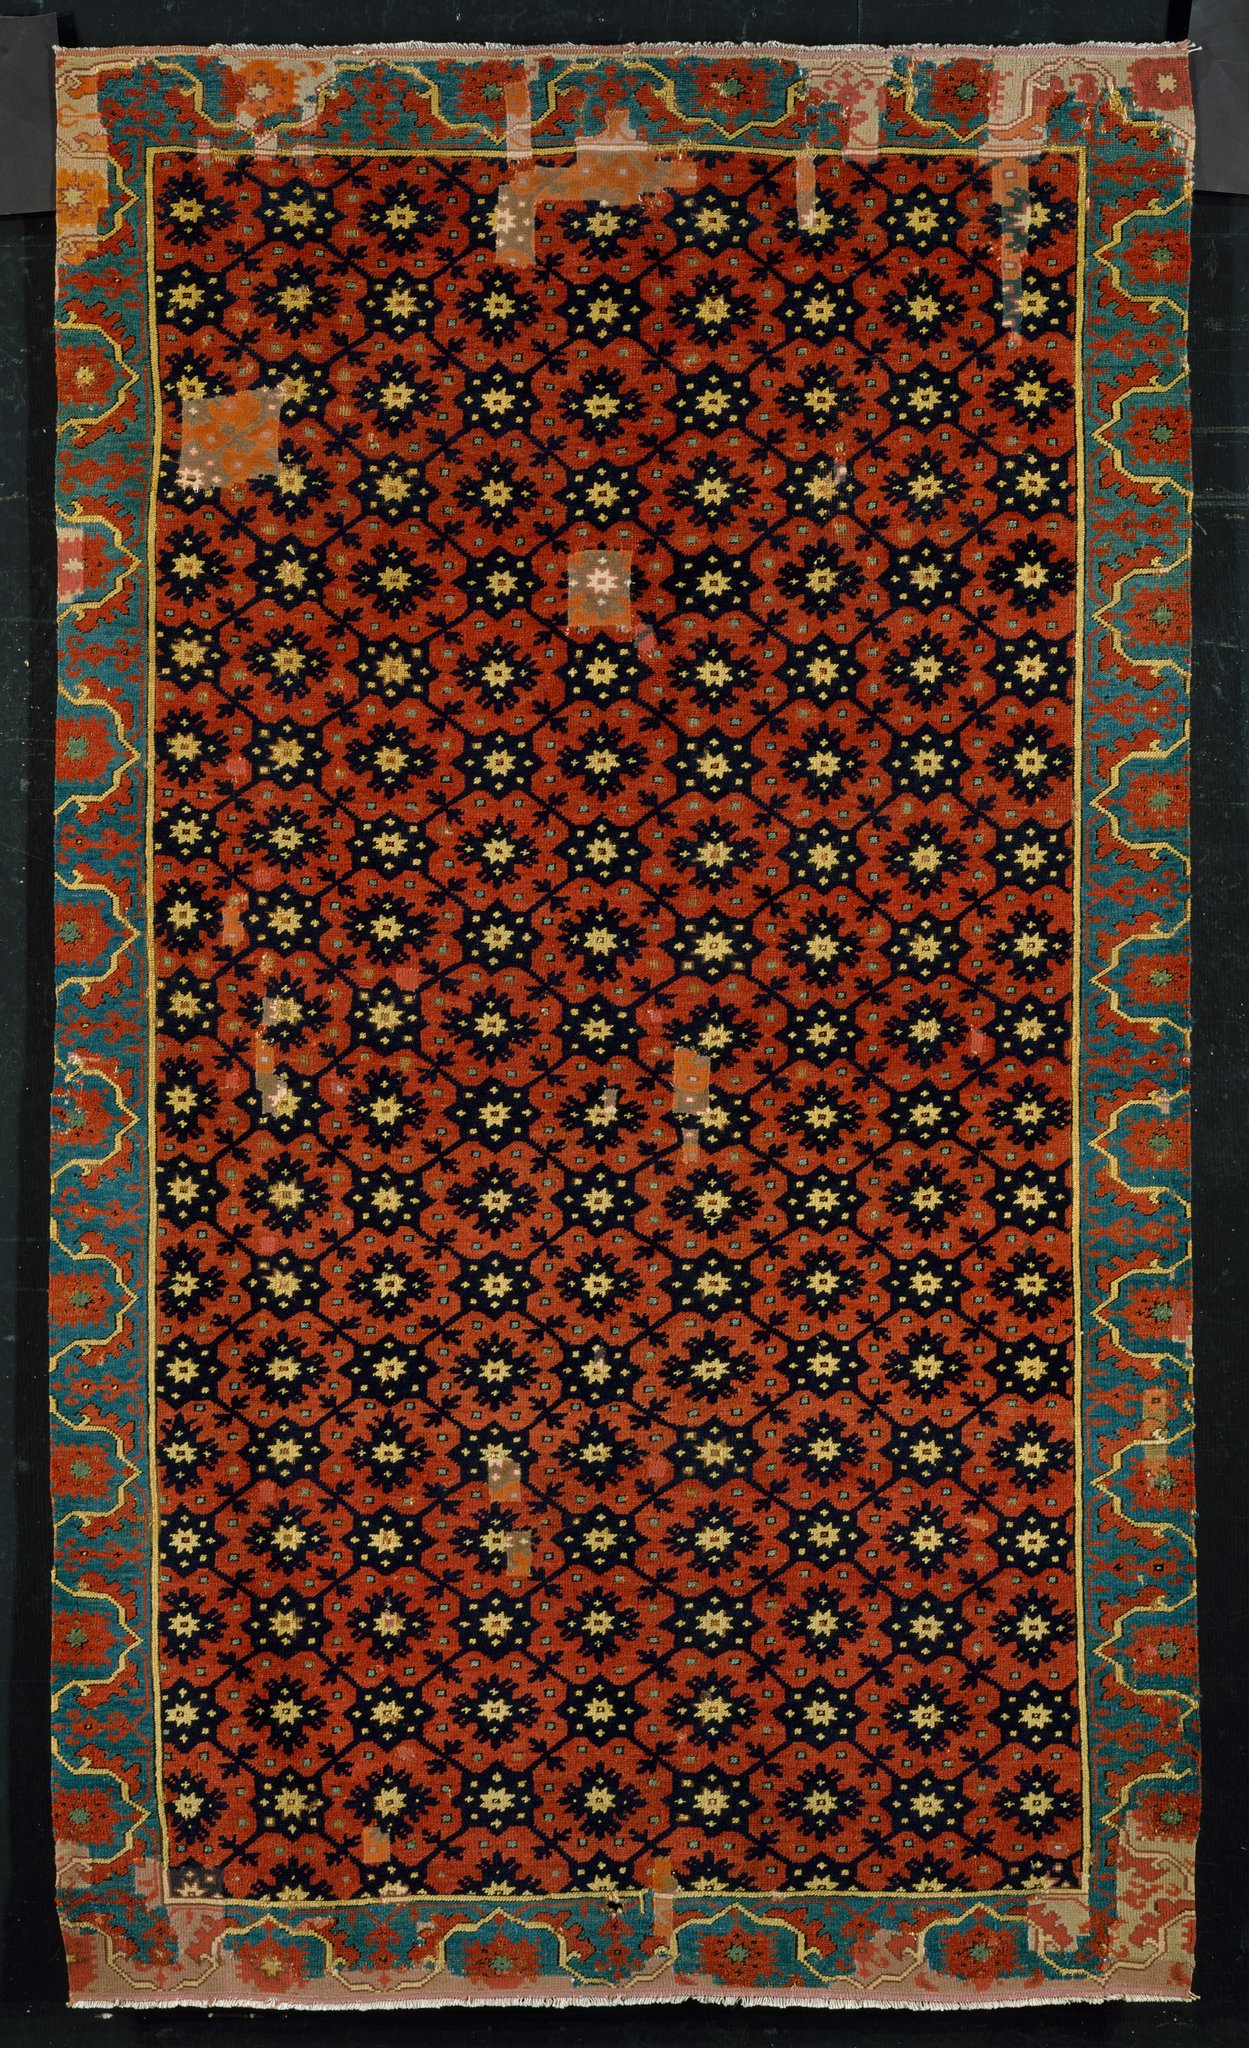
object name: carpet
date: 1501-1533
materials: wool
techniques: pile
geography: turkey